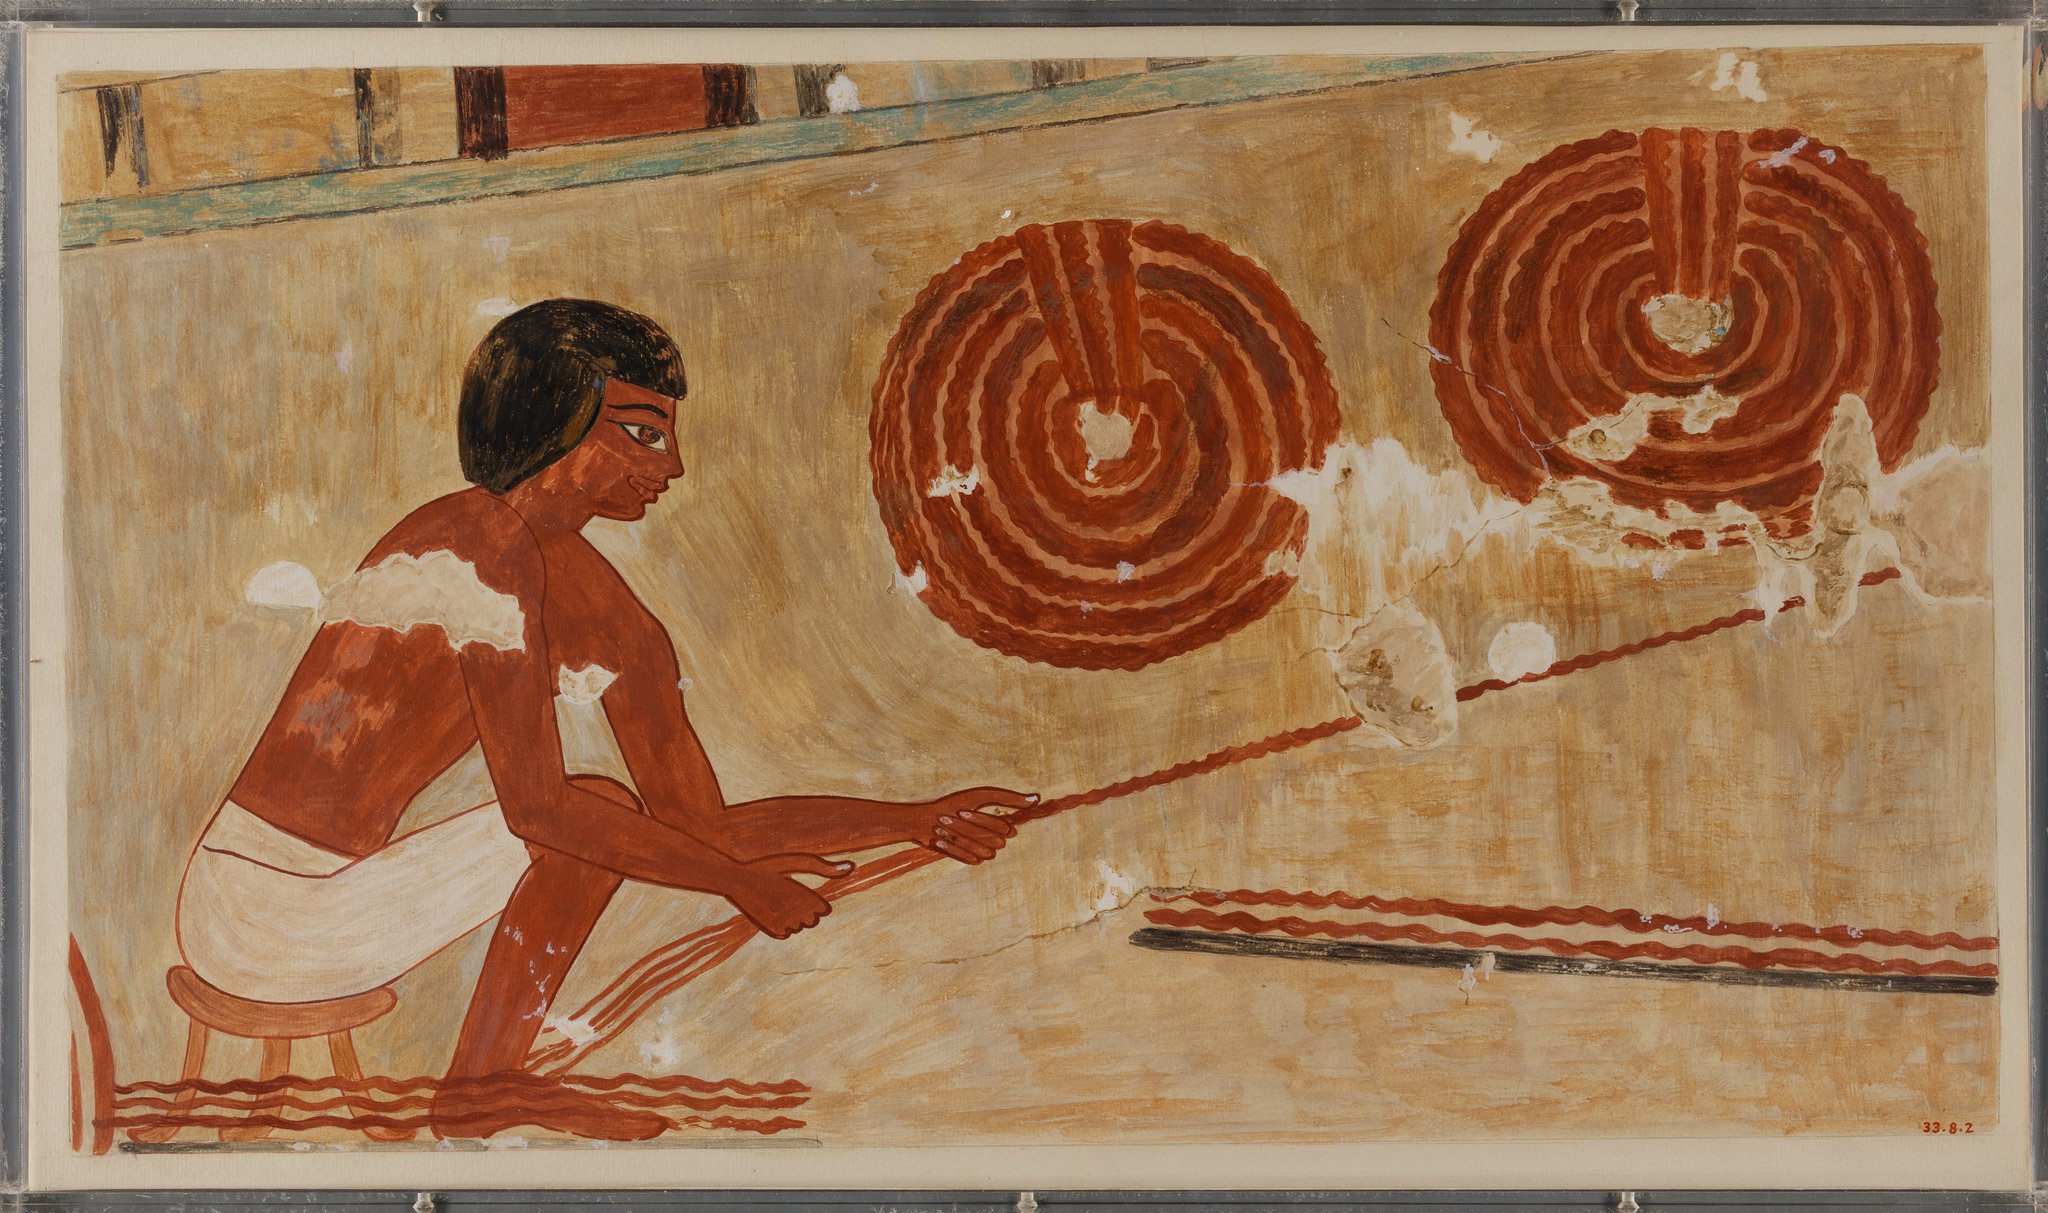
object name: facsimile, rekhmire tt 100, rope making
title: Man Making Leather Rope, Tomb of Rekhmire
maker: nina de garis davies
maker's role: artist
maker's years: 1881-1965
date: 1479-1400 BCE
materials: paper, paint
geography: egypt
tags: men,working